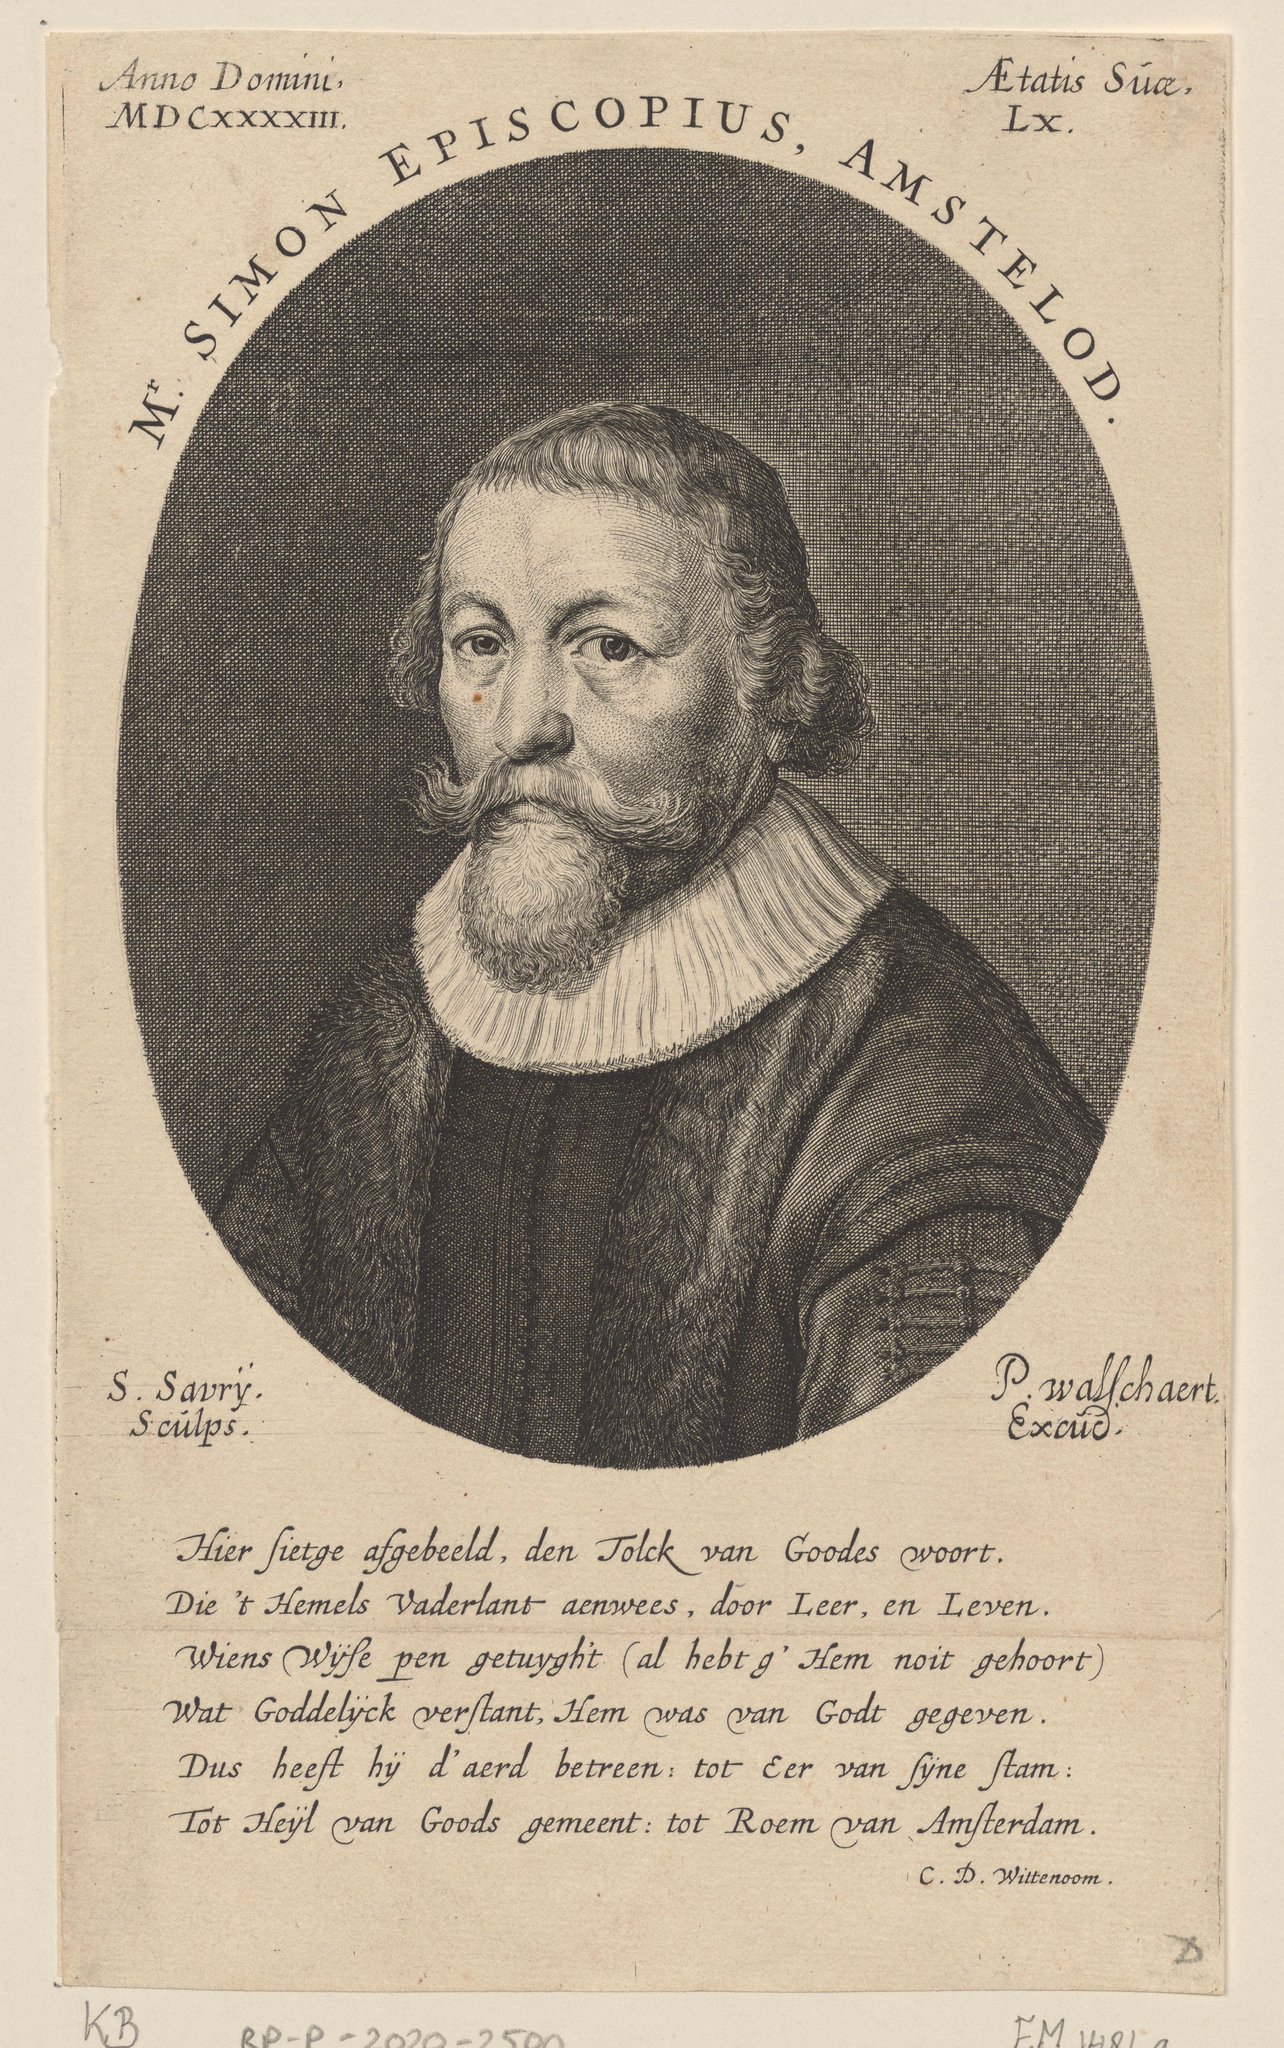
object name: print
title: Portret van Simon Episcopius op 60-jarige leeftijd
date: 1643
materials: paper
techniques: engraving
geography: amsterdam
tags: theologian, historical persons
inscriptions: collector's mark: Lugt 240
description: Met zesregelig vers in het Nederlands onder het portret.